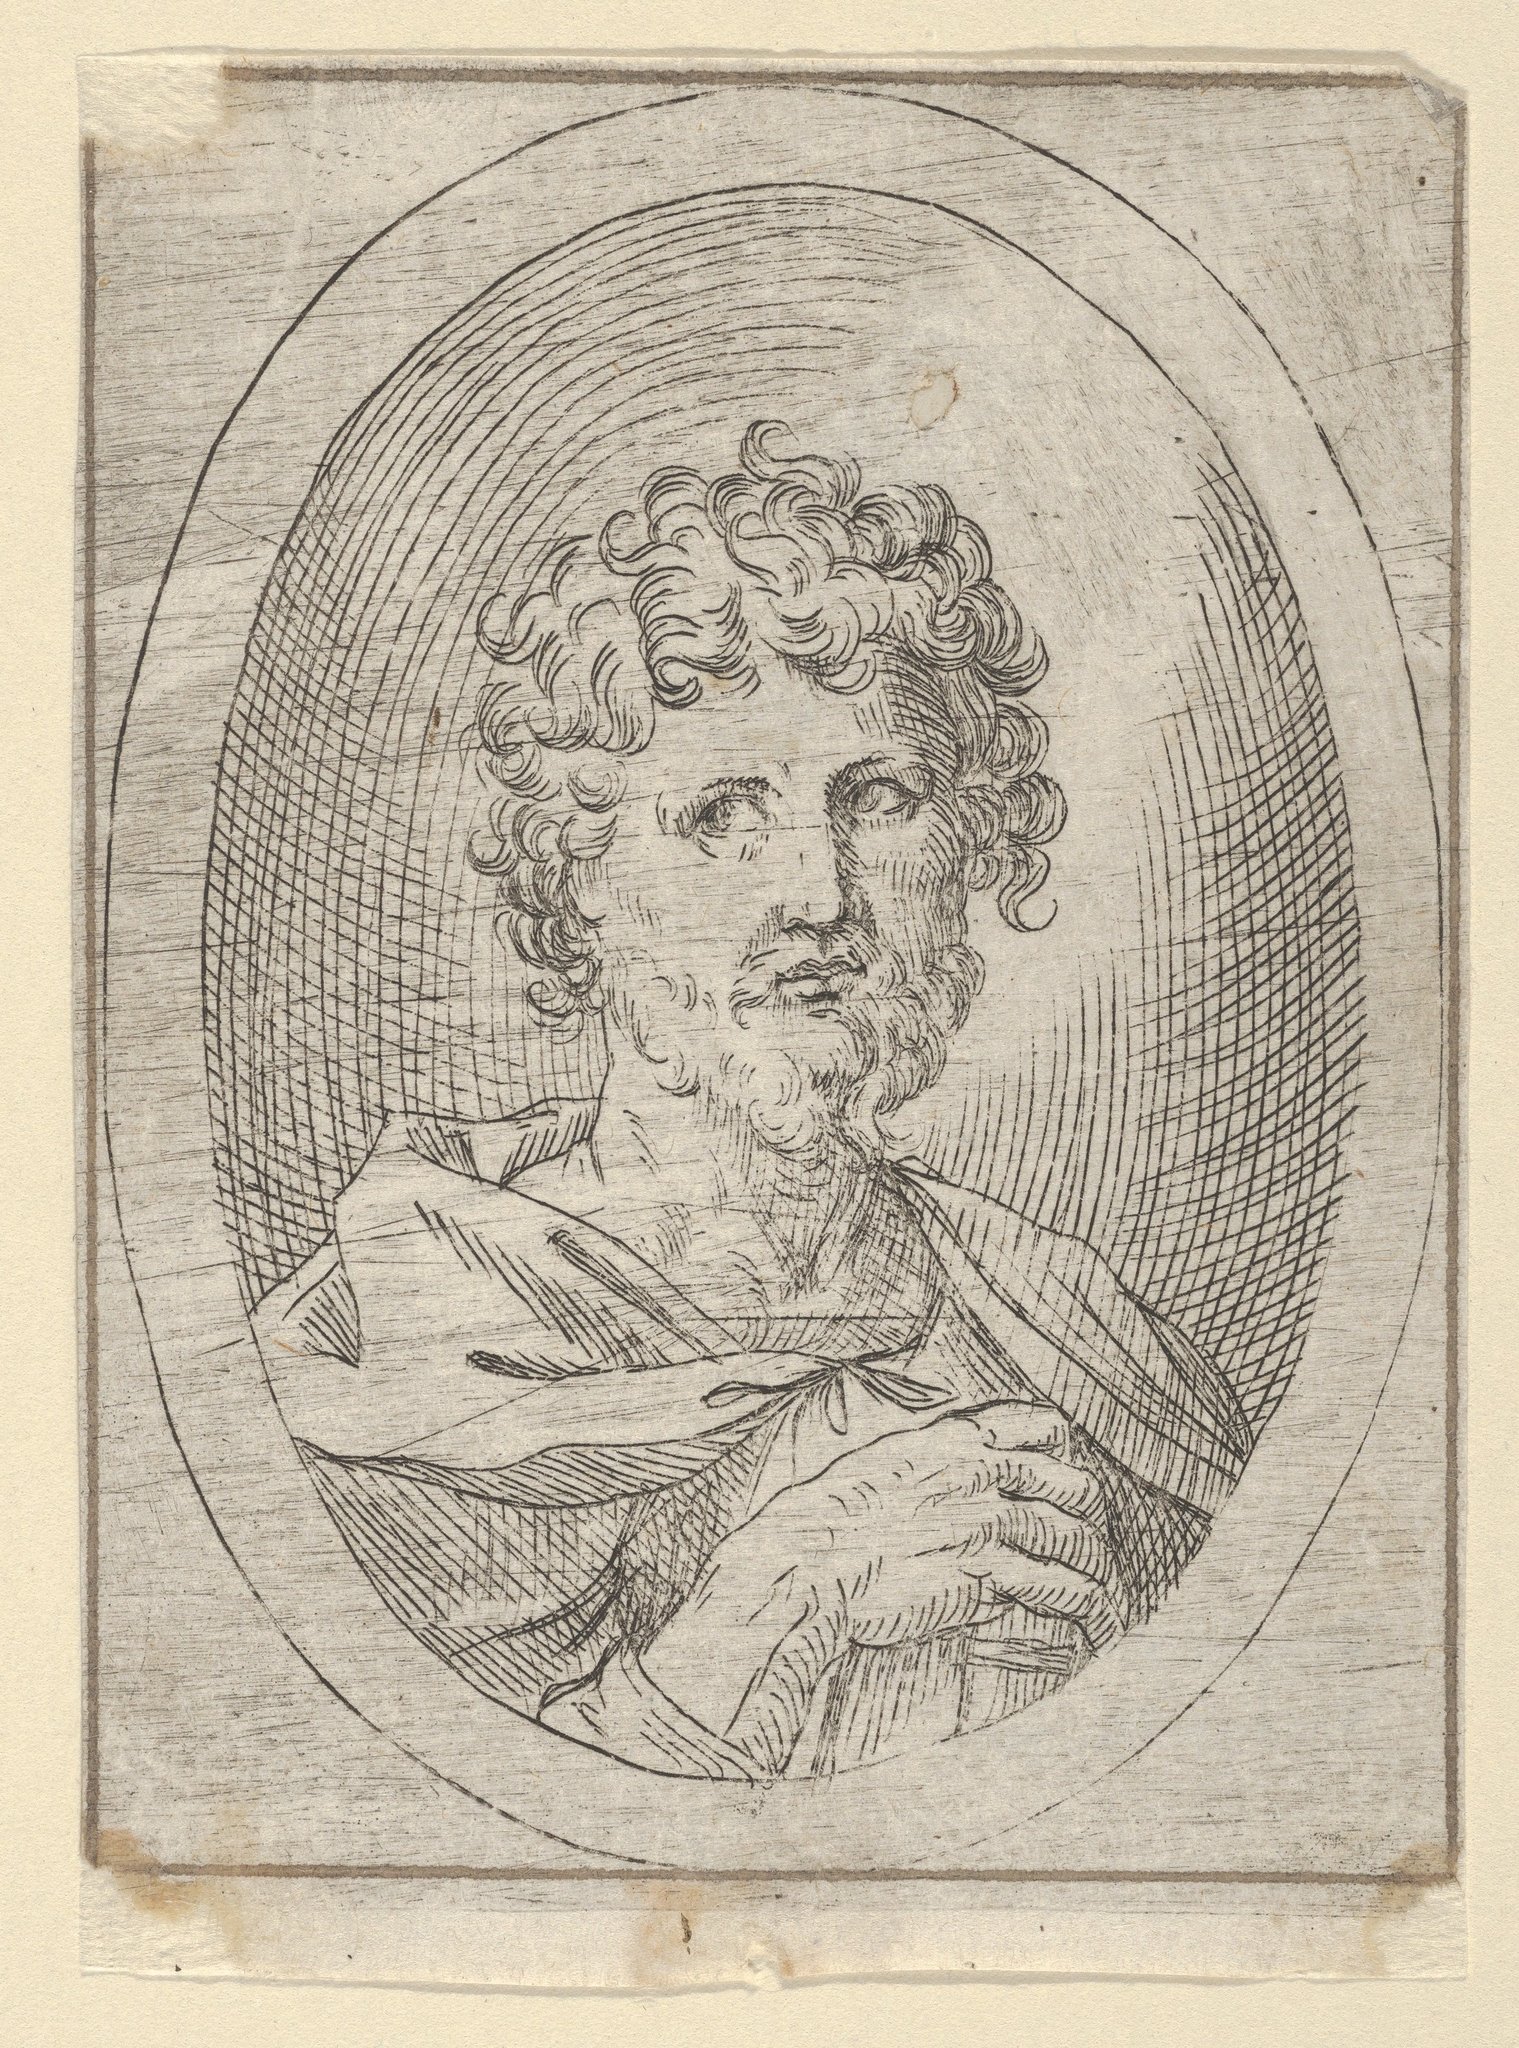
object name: print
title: An apostle holding a closed book and looking to the left, in an oval frame, from "Christ, the Virgin, and Thirteen Apostles"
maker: anonymous, 17th century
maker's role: artist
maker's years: 1600-1700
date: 1600-1640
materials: ink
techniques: etching, pen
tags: portraits,apostles